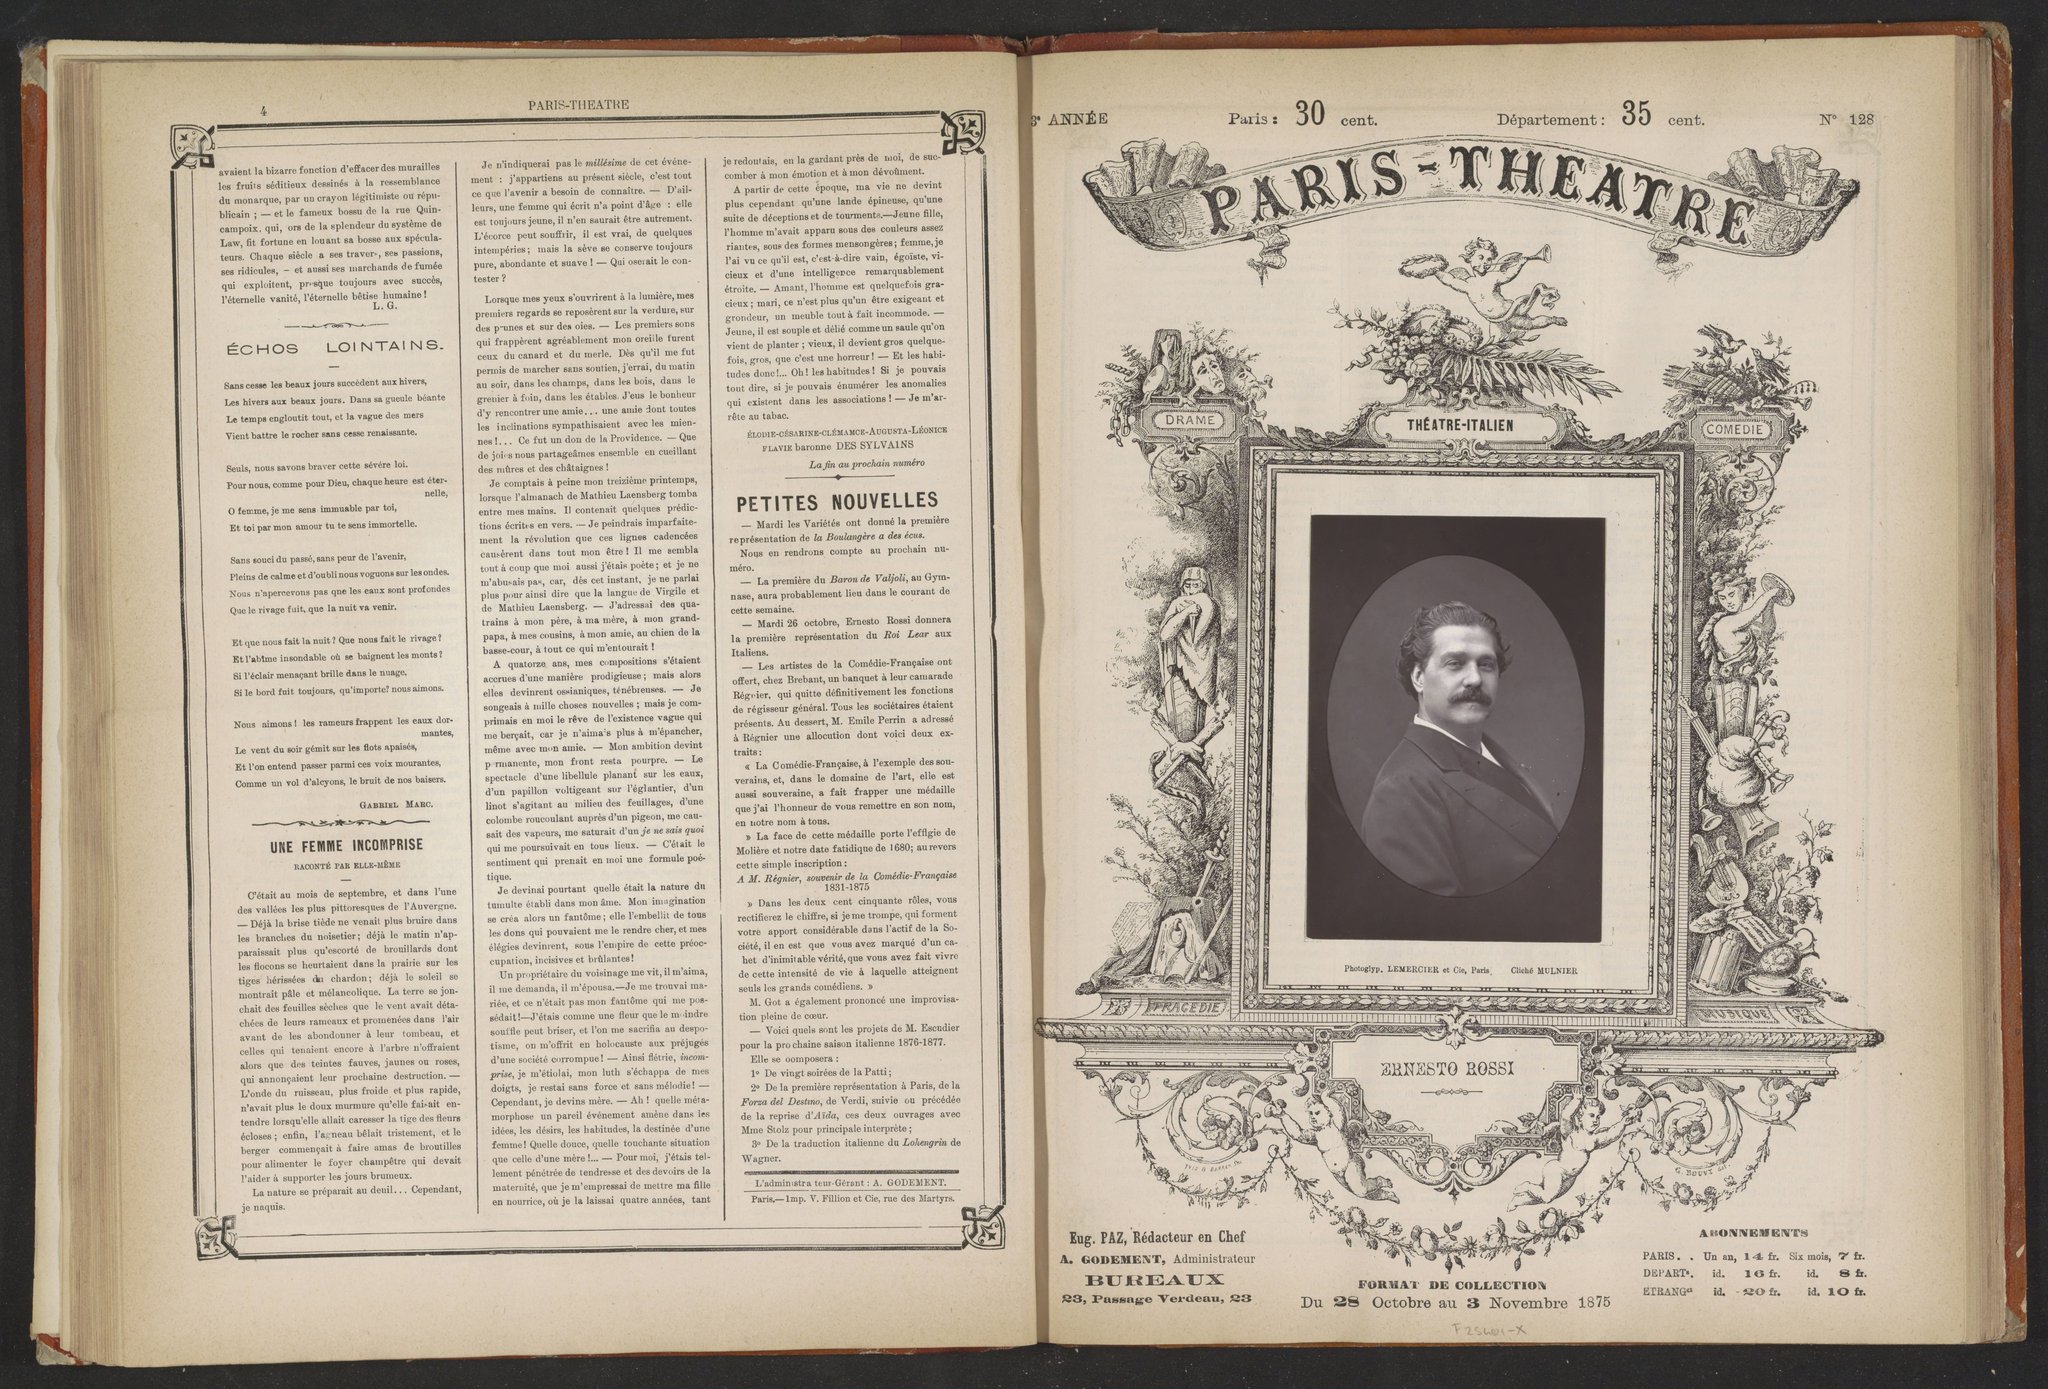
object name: page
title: Portret van Ernesto Rossi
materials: paper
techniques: woodburytype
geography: france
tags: acteur, ernesto rossi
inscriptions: inscription: ‘Du 28 Octobre au 3 Novembre 1875’, number: ‘No 128’